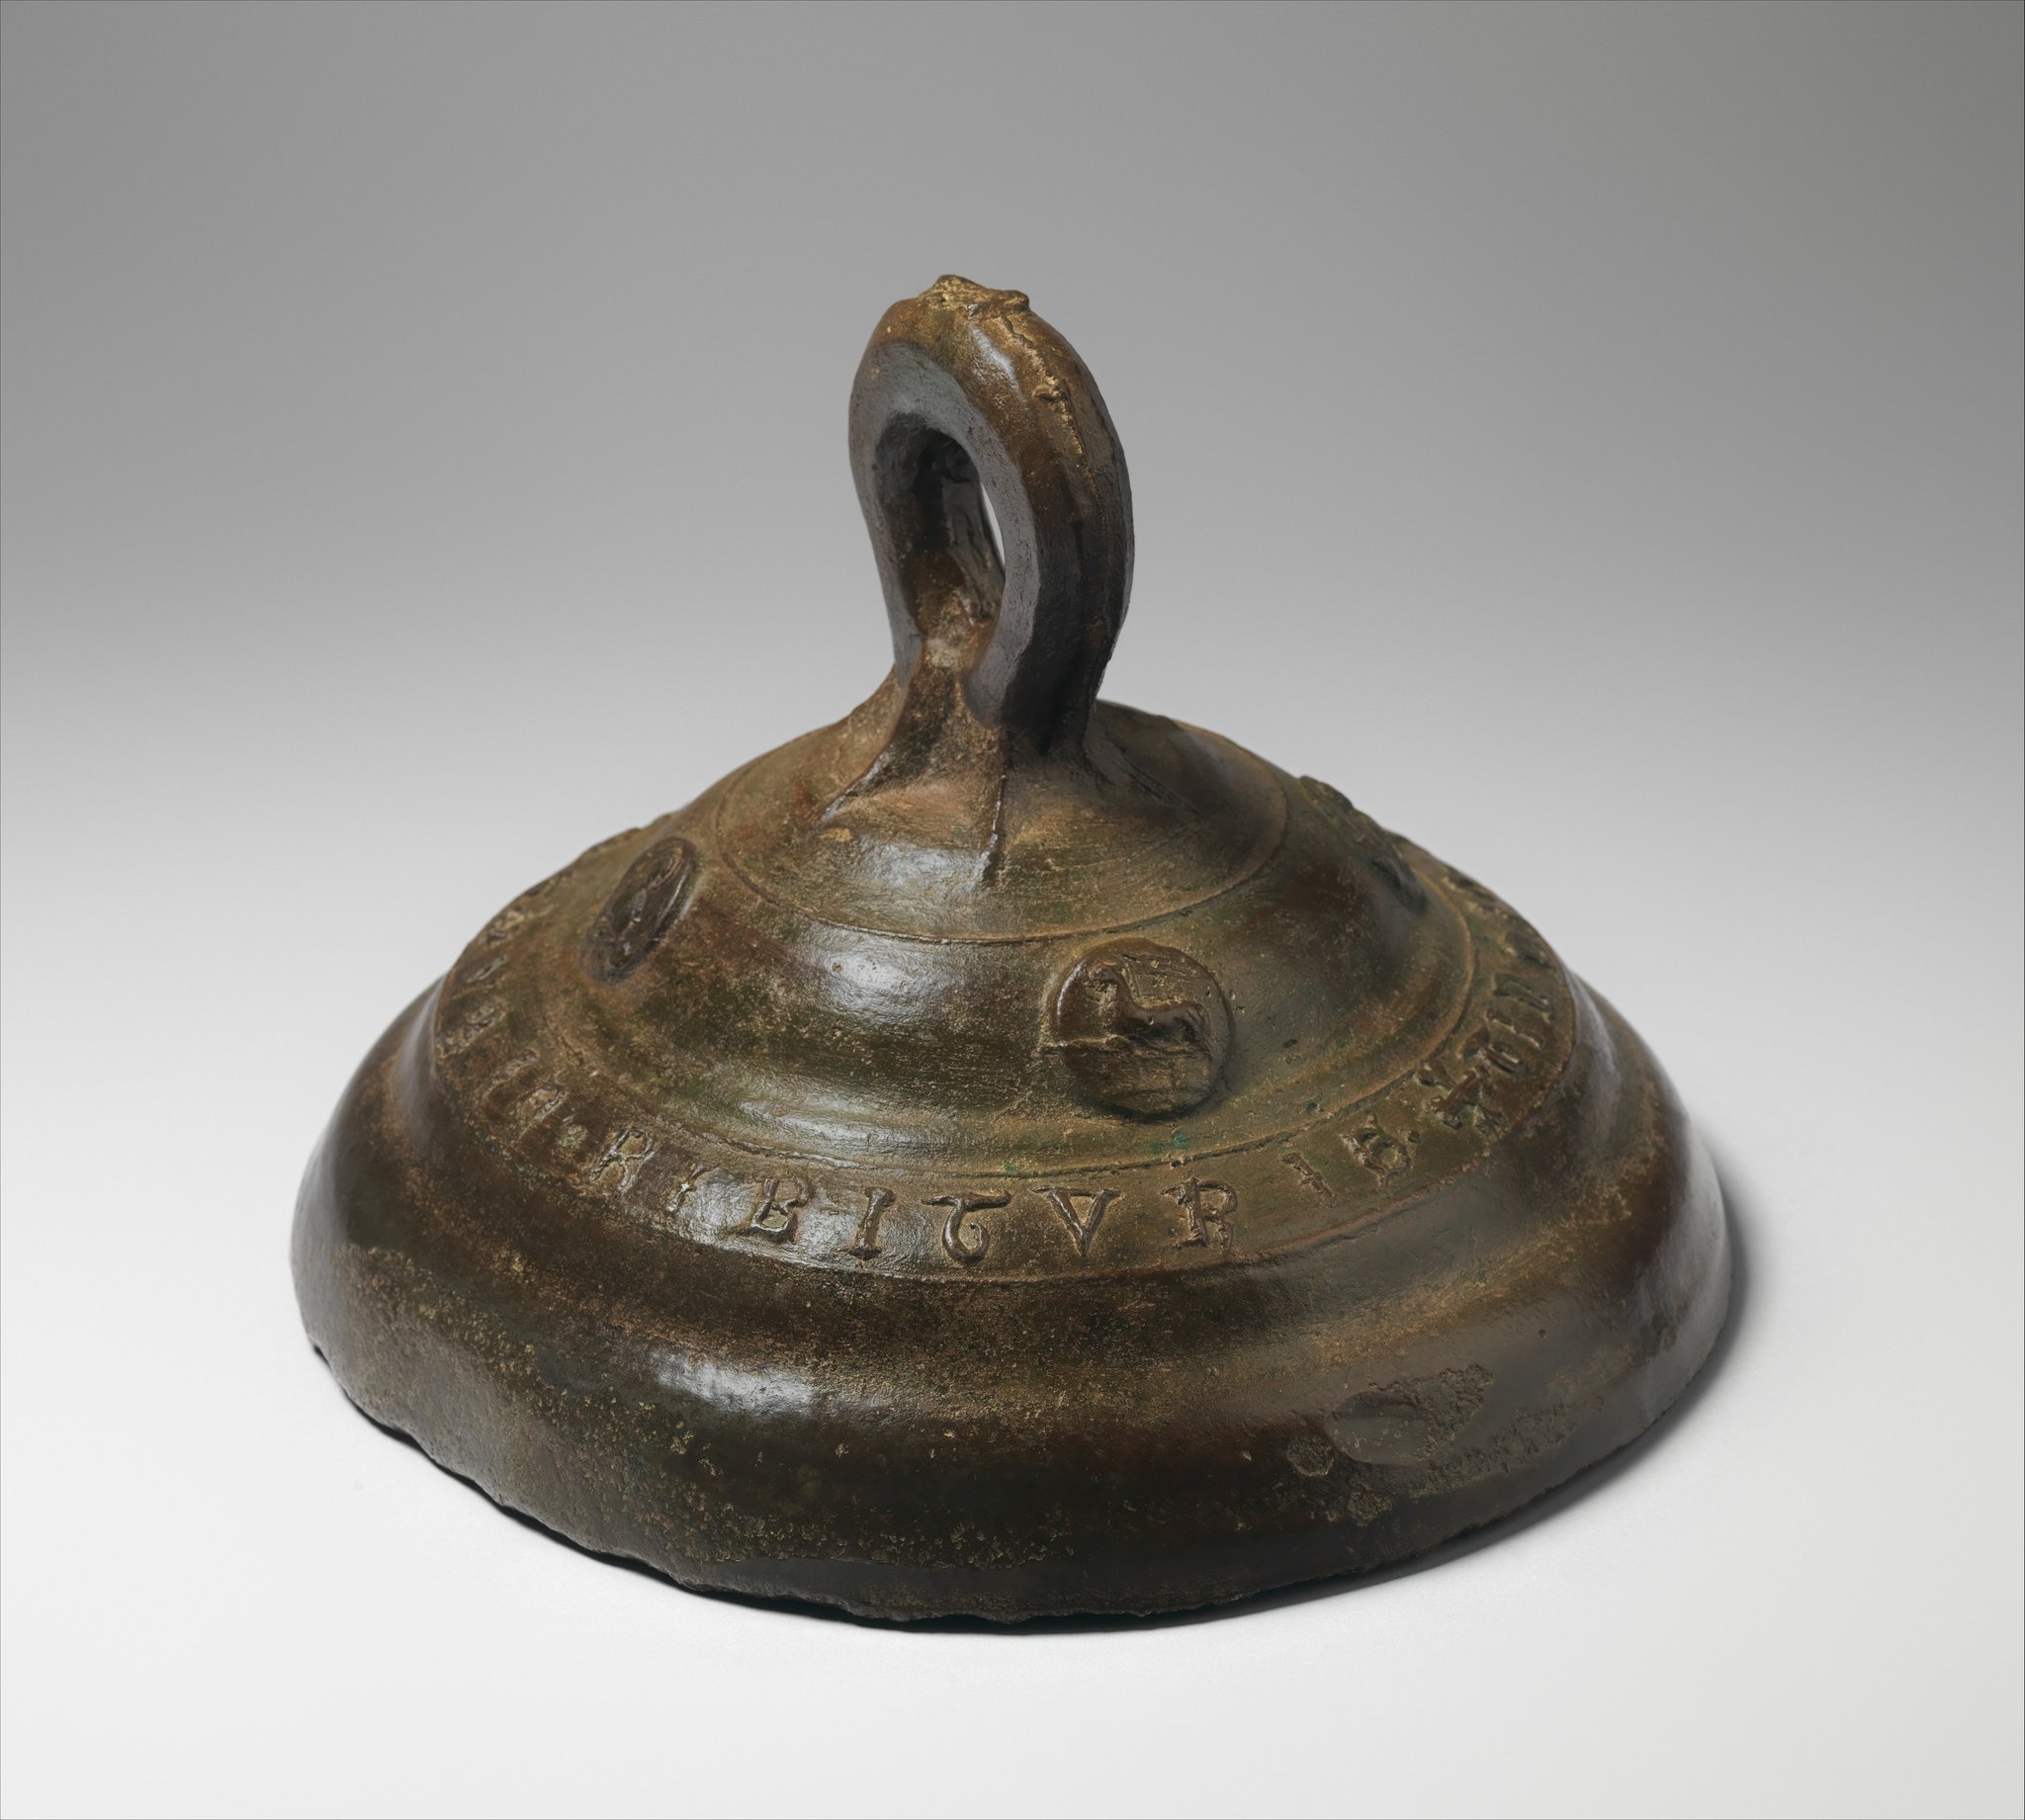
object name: bell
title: Refectory Bell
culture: german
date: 1201-1300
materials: copper alloy